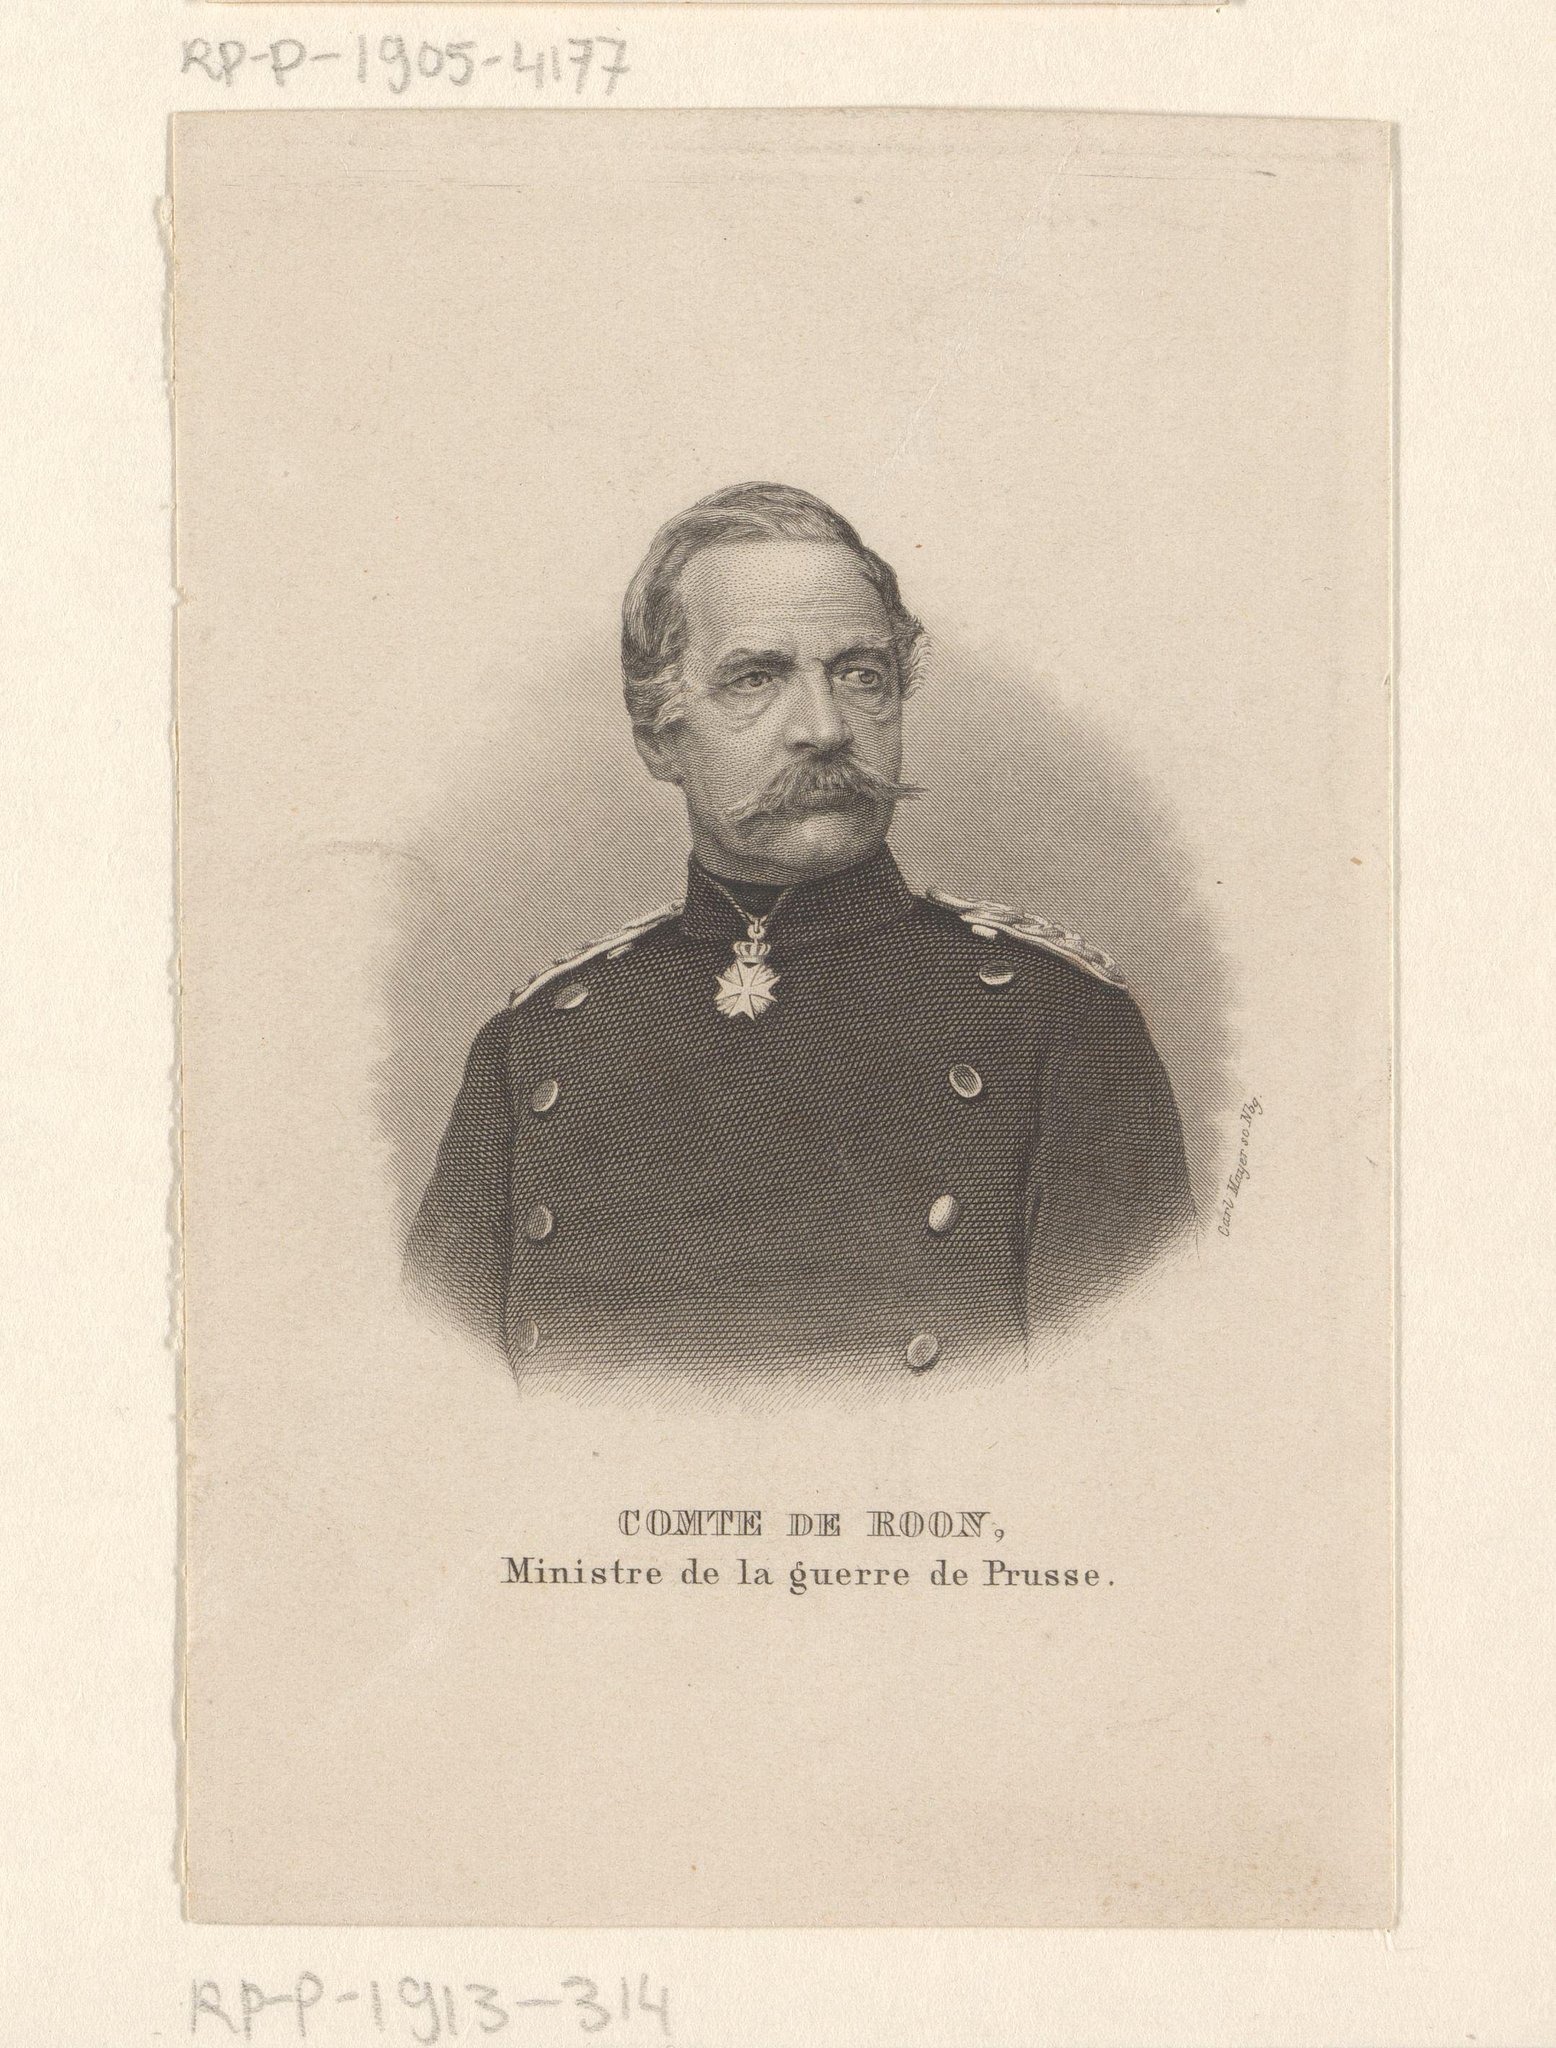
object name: print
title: Portret van Albrecht Theodor Emil von Roon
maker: carl mayer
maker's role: print maker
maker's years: 1798-1868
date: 1830-1868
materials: paper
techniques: engraving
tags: commander-in-chief, general, marshal, historical persons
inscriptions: collector's mark: Lugt 2228